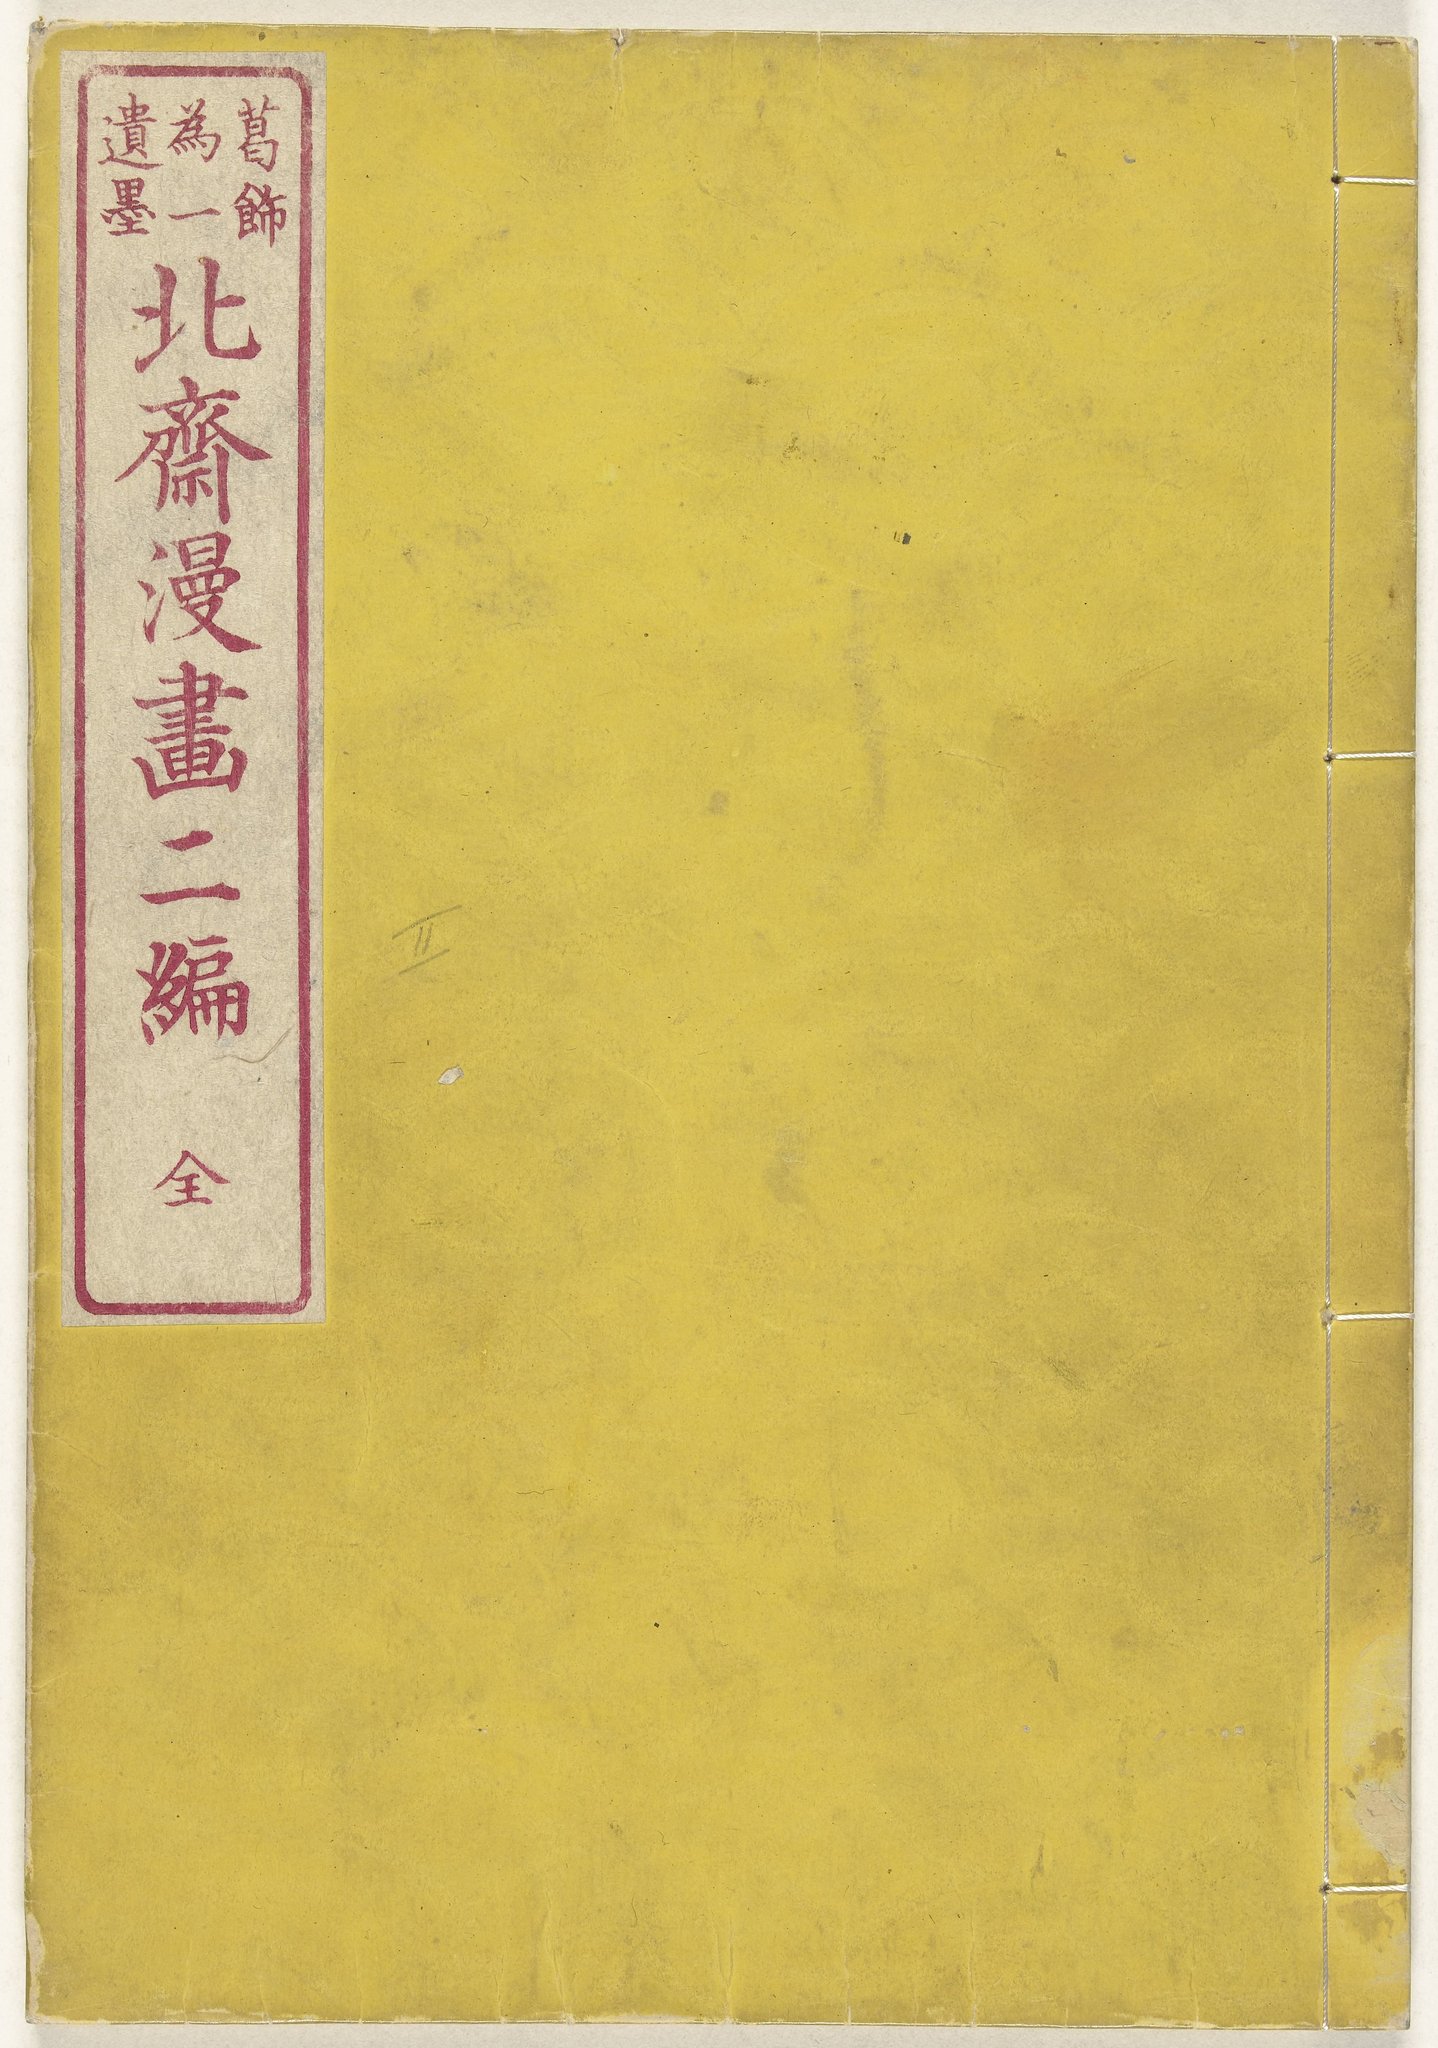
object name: book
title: Katsushika iitsu iboku Hokusai manga nihen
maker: katsushika hokusai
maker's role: draughtsman, print maker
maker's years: 1760-1849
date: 1878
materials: paper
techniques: woodcut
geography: tokyo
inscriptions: collector's mark: Lugt 2228, collector's mark: ‘Rijksschool voor kunstnijverheid’ Lugt 3937